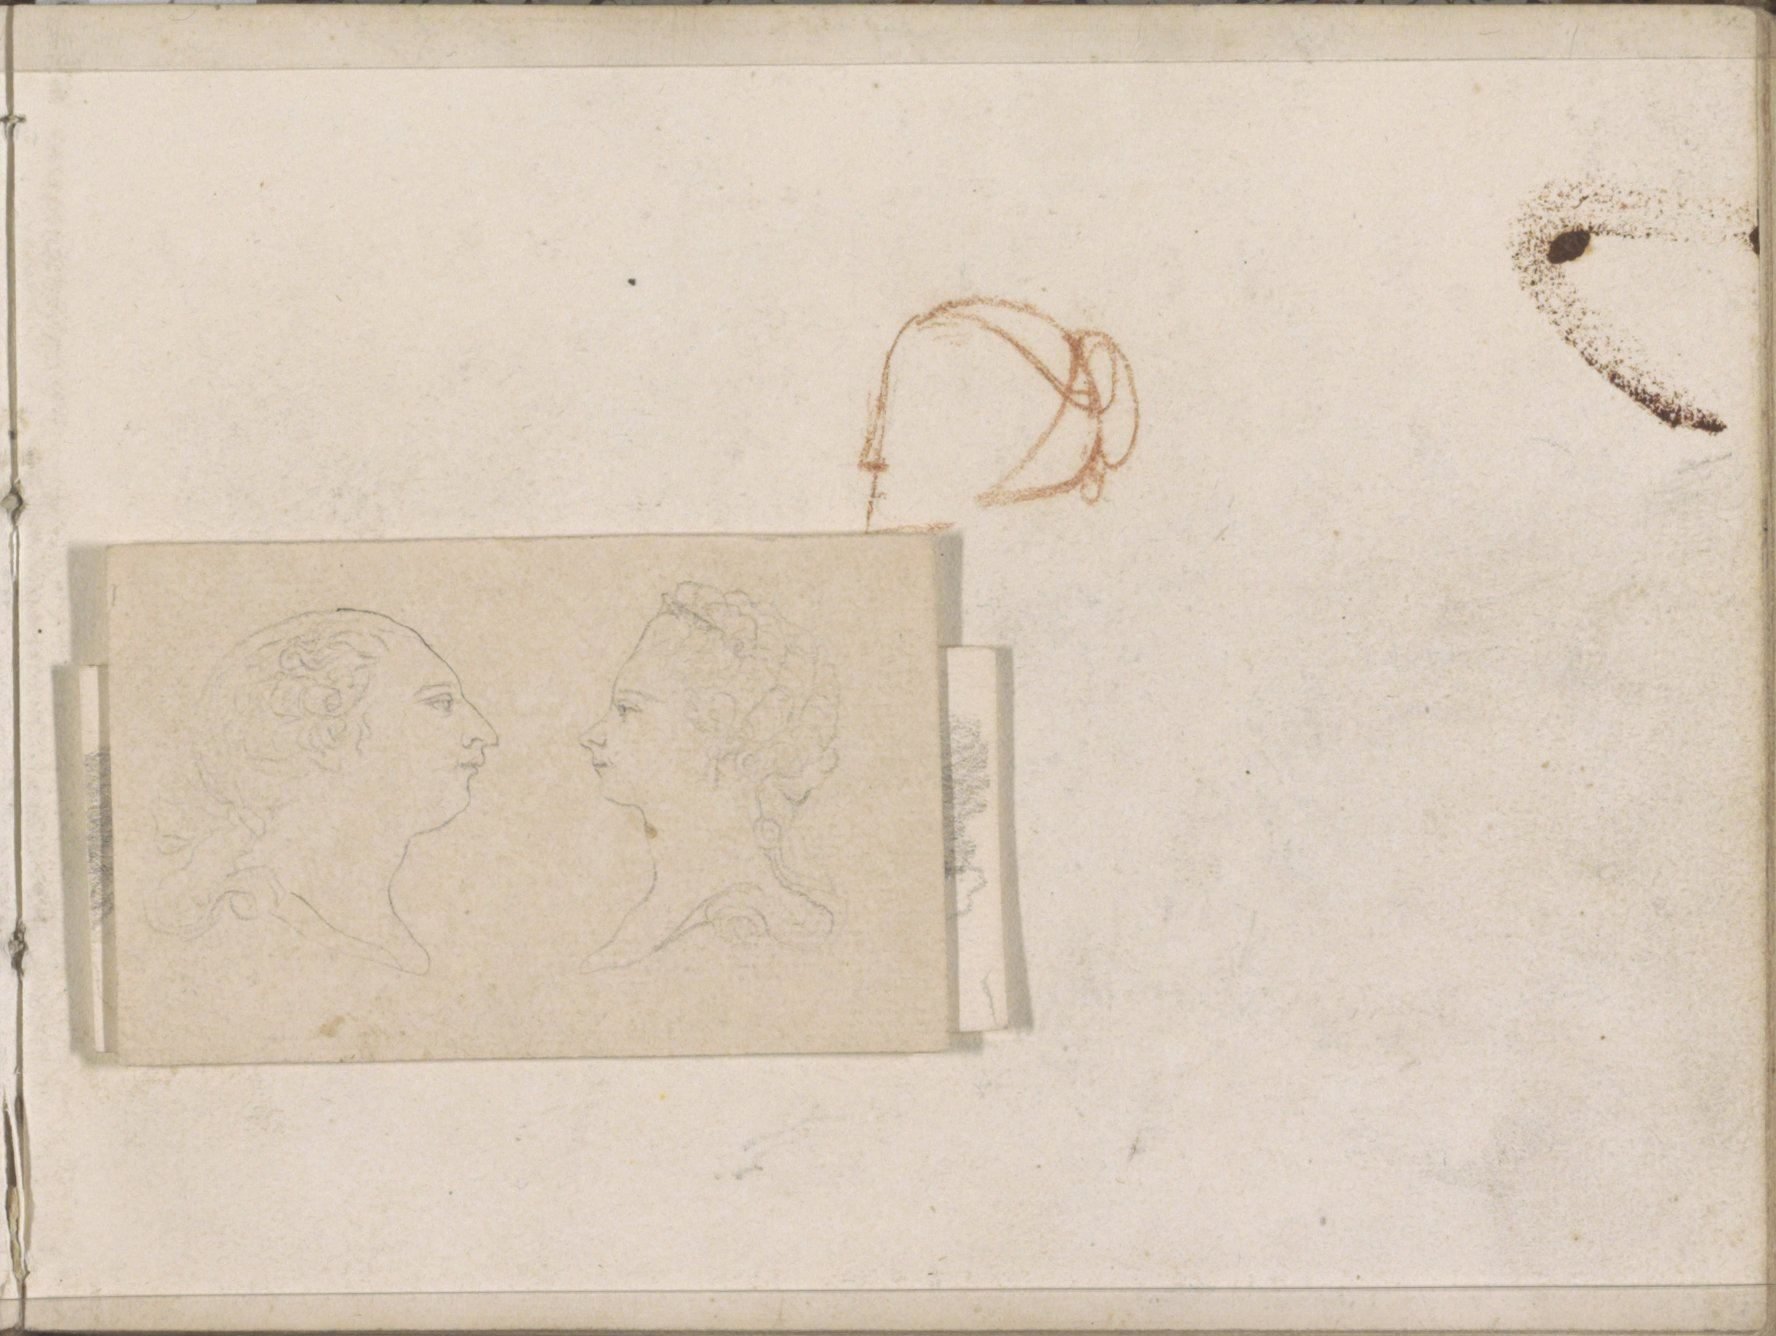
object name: sketchbook leaf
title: Twee vrouwenkoppen, in profiel naar elkaar gericht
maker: maria vos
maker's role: draughtsman, painter, print maker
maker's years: 1824-1906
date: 1834-1906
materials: paper, pencil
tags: head (human) (+ female (human being) (not to be used where -aa- is prescribed))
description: Los blad tussen het voorste schutblad en pagina 1 van een schetsboek met 21 bladen.